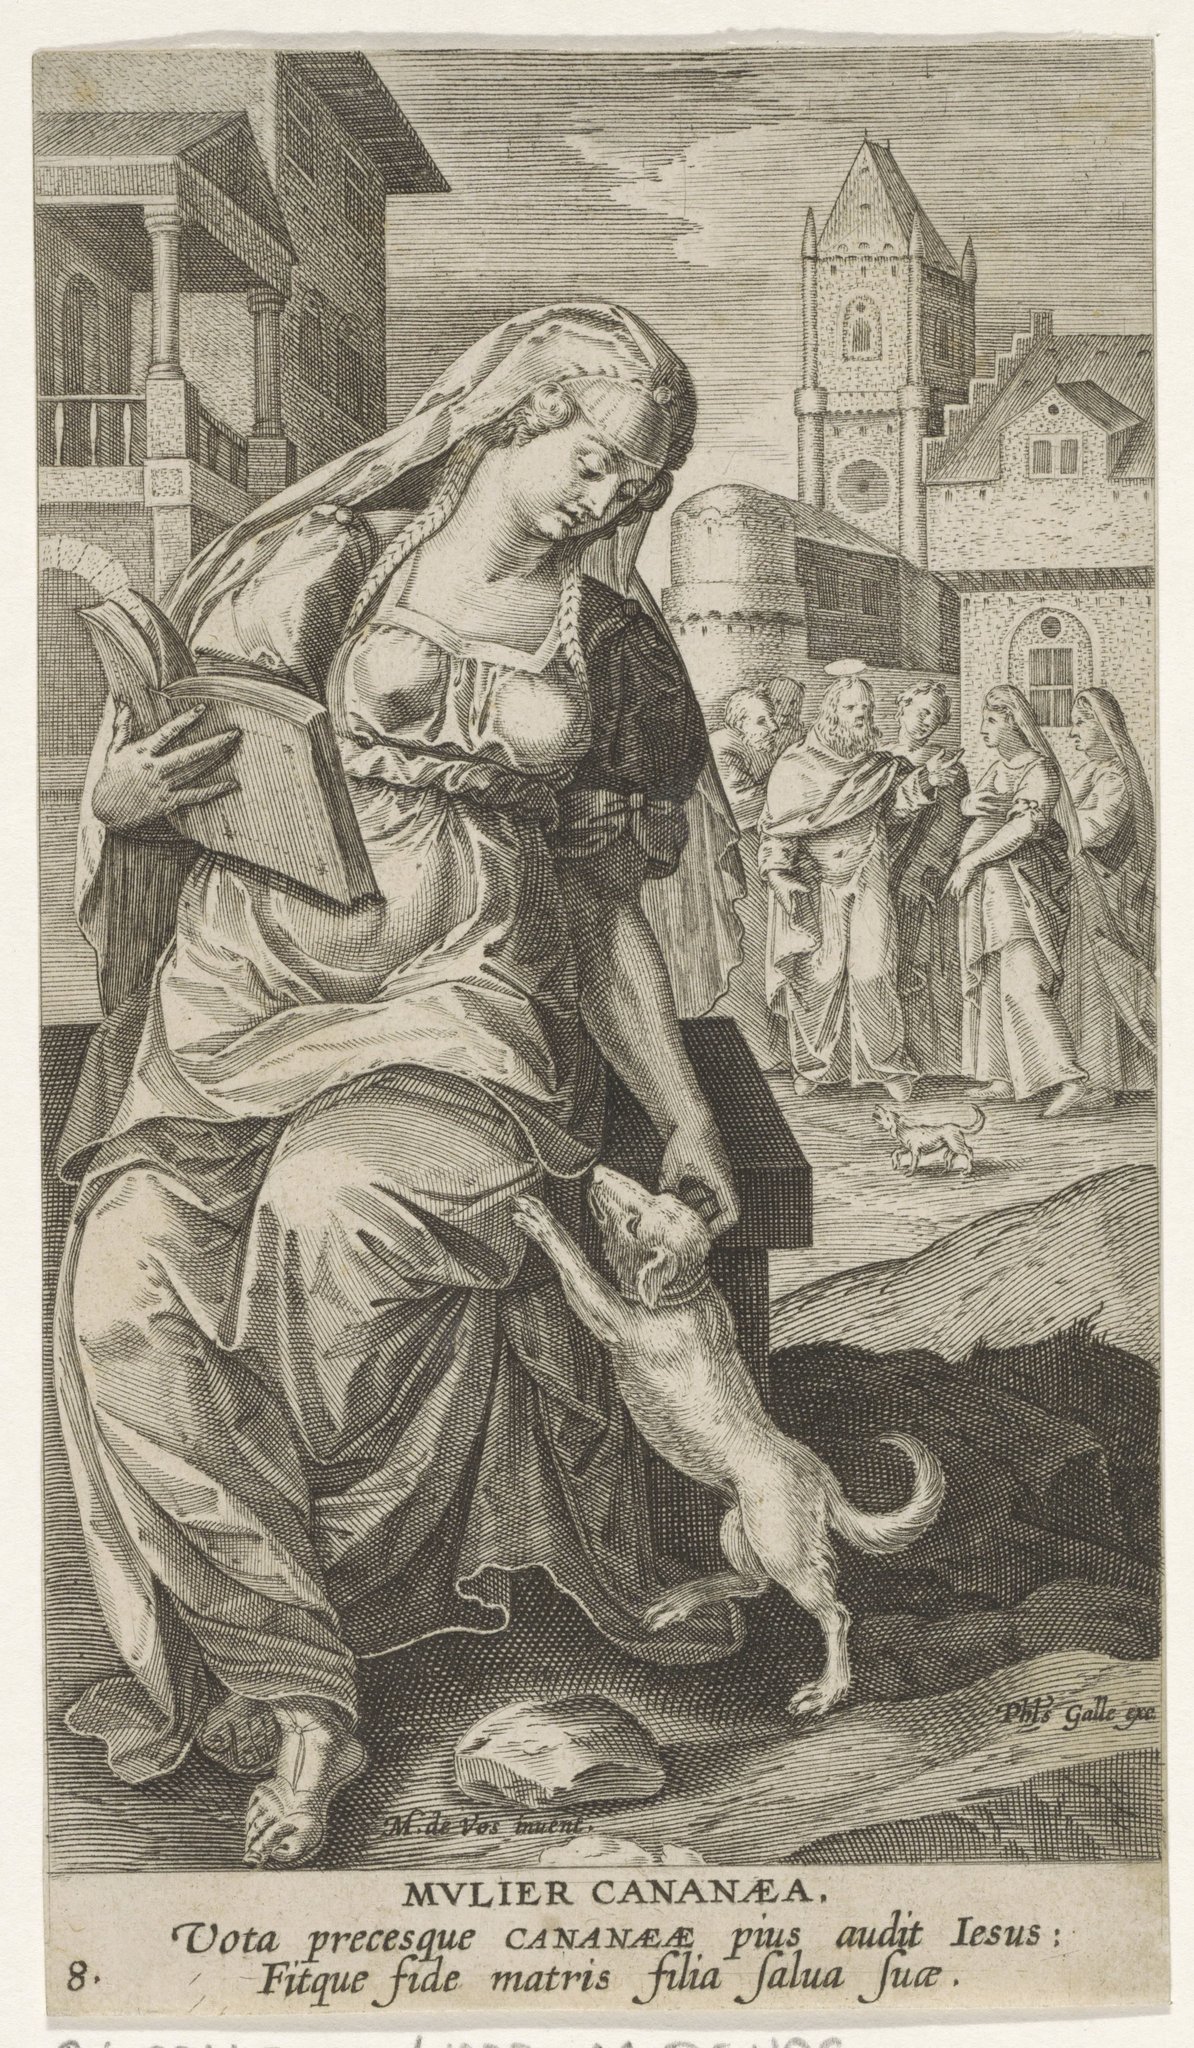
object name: print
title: Beroemde vrouwen uit het Nieuwe Testament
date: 1595-1599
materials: paper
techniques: engraving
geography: antwerp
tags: female persons from the new testament (not in biblical context), a canaanite woman kneels before christ, asking him to heal her daughter; the metaphor of the dogs and bread (matthew 15:21-28; mark 7:24-30), dog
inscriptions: collector's mark: Lugt 2228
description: Op de voorgrond de Kanaänitische vrouw. Op de achtergrond is zij in gesprek met Christus. Naast de vrouw een hond als verwijzing naar de gelijkenis die Christus aan de vrouw verteld. De prent heeft een Latijns onderschrift en maakt deel uit van een prentserie met beroemde vrouwen uit het Nieuwe Testament.